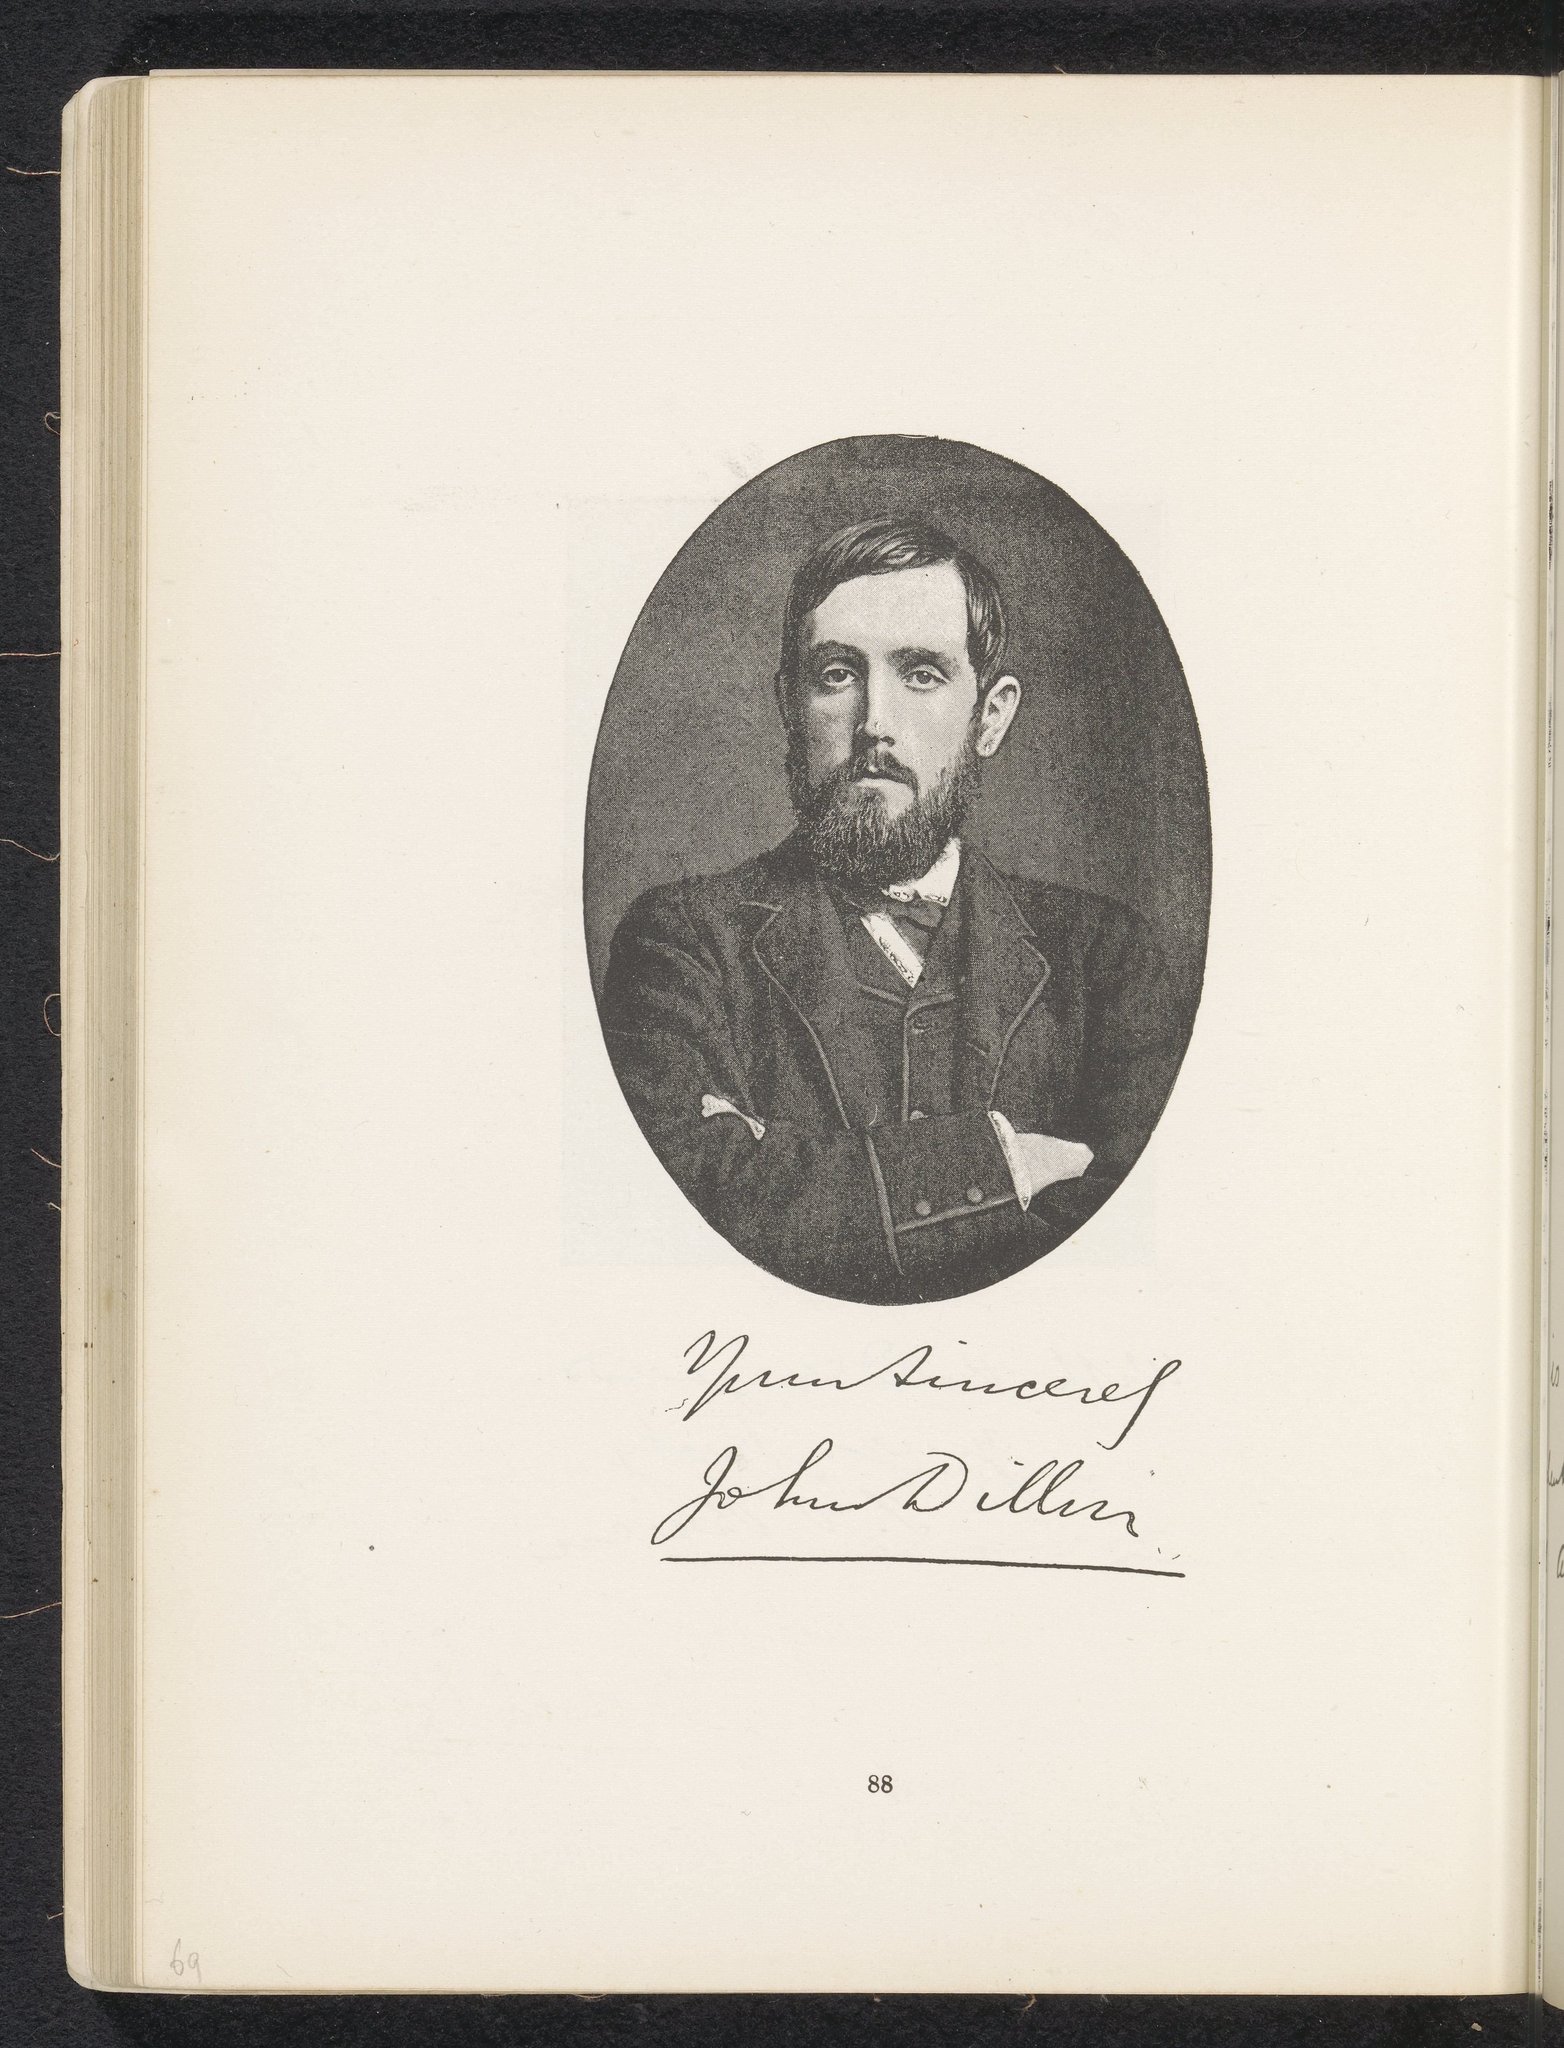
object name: page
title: Portret van John Dillon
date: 1881-1891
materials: paper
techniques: autotype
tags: politician, politician, e.g. party leader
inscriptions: inscription